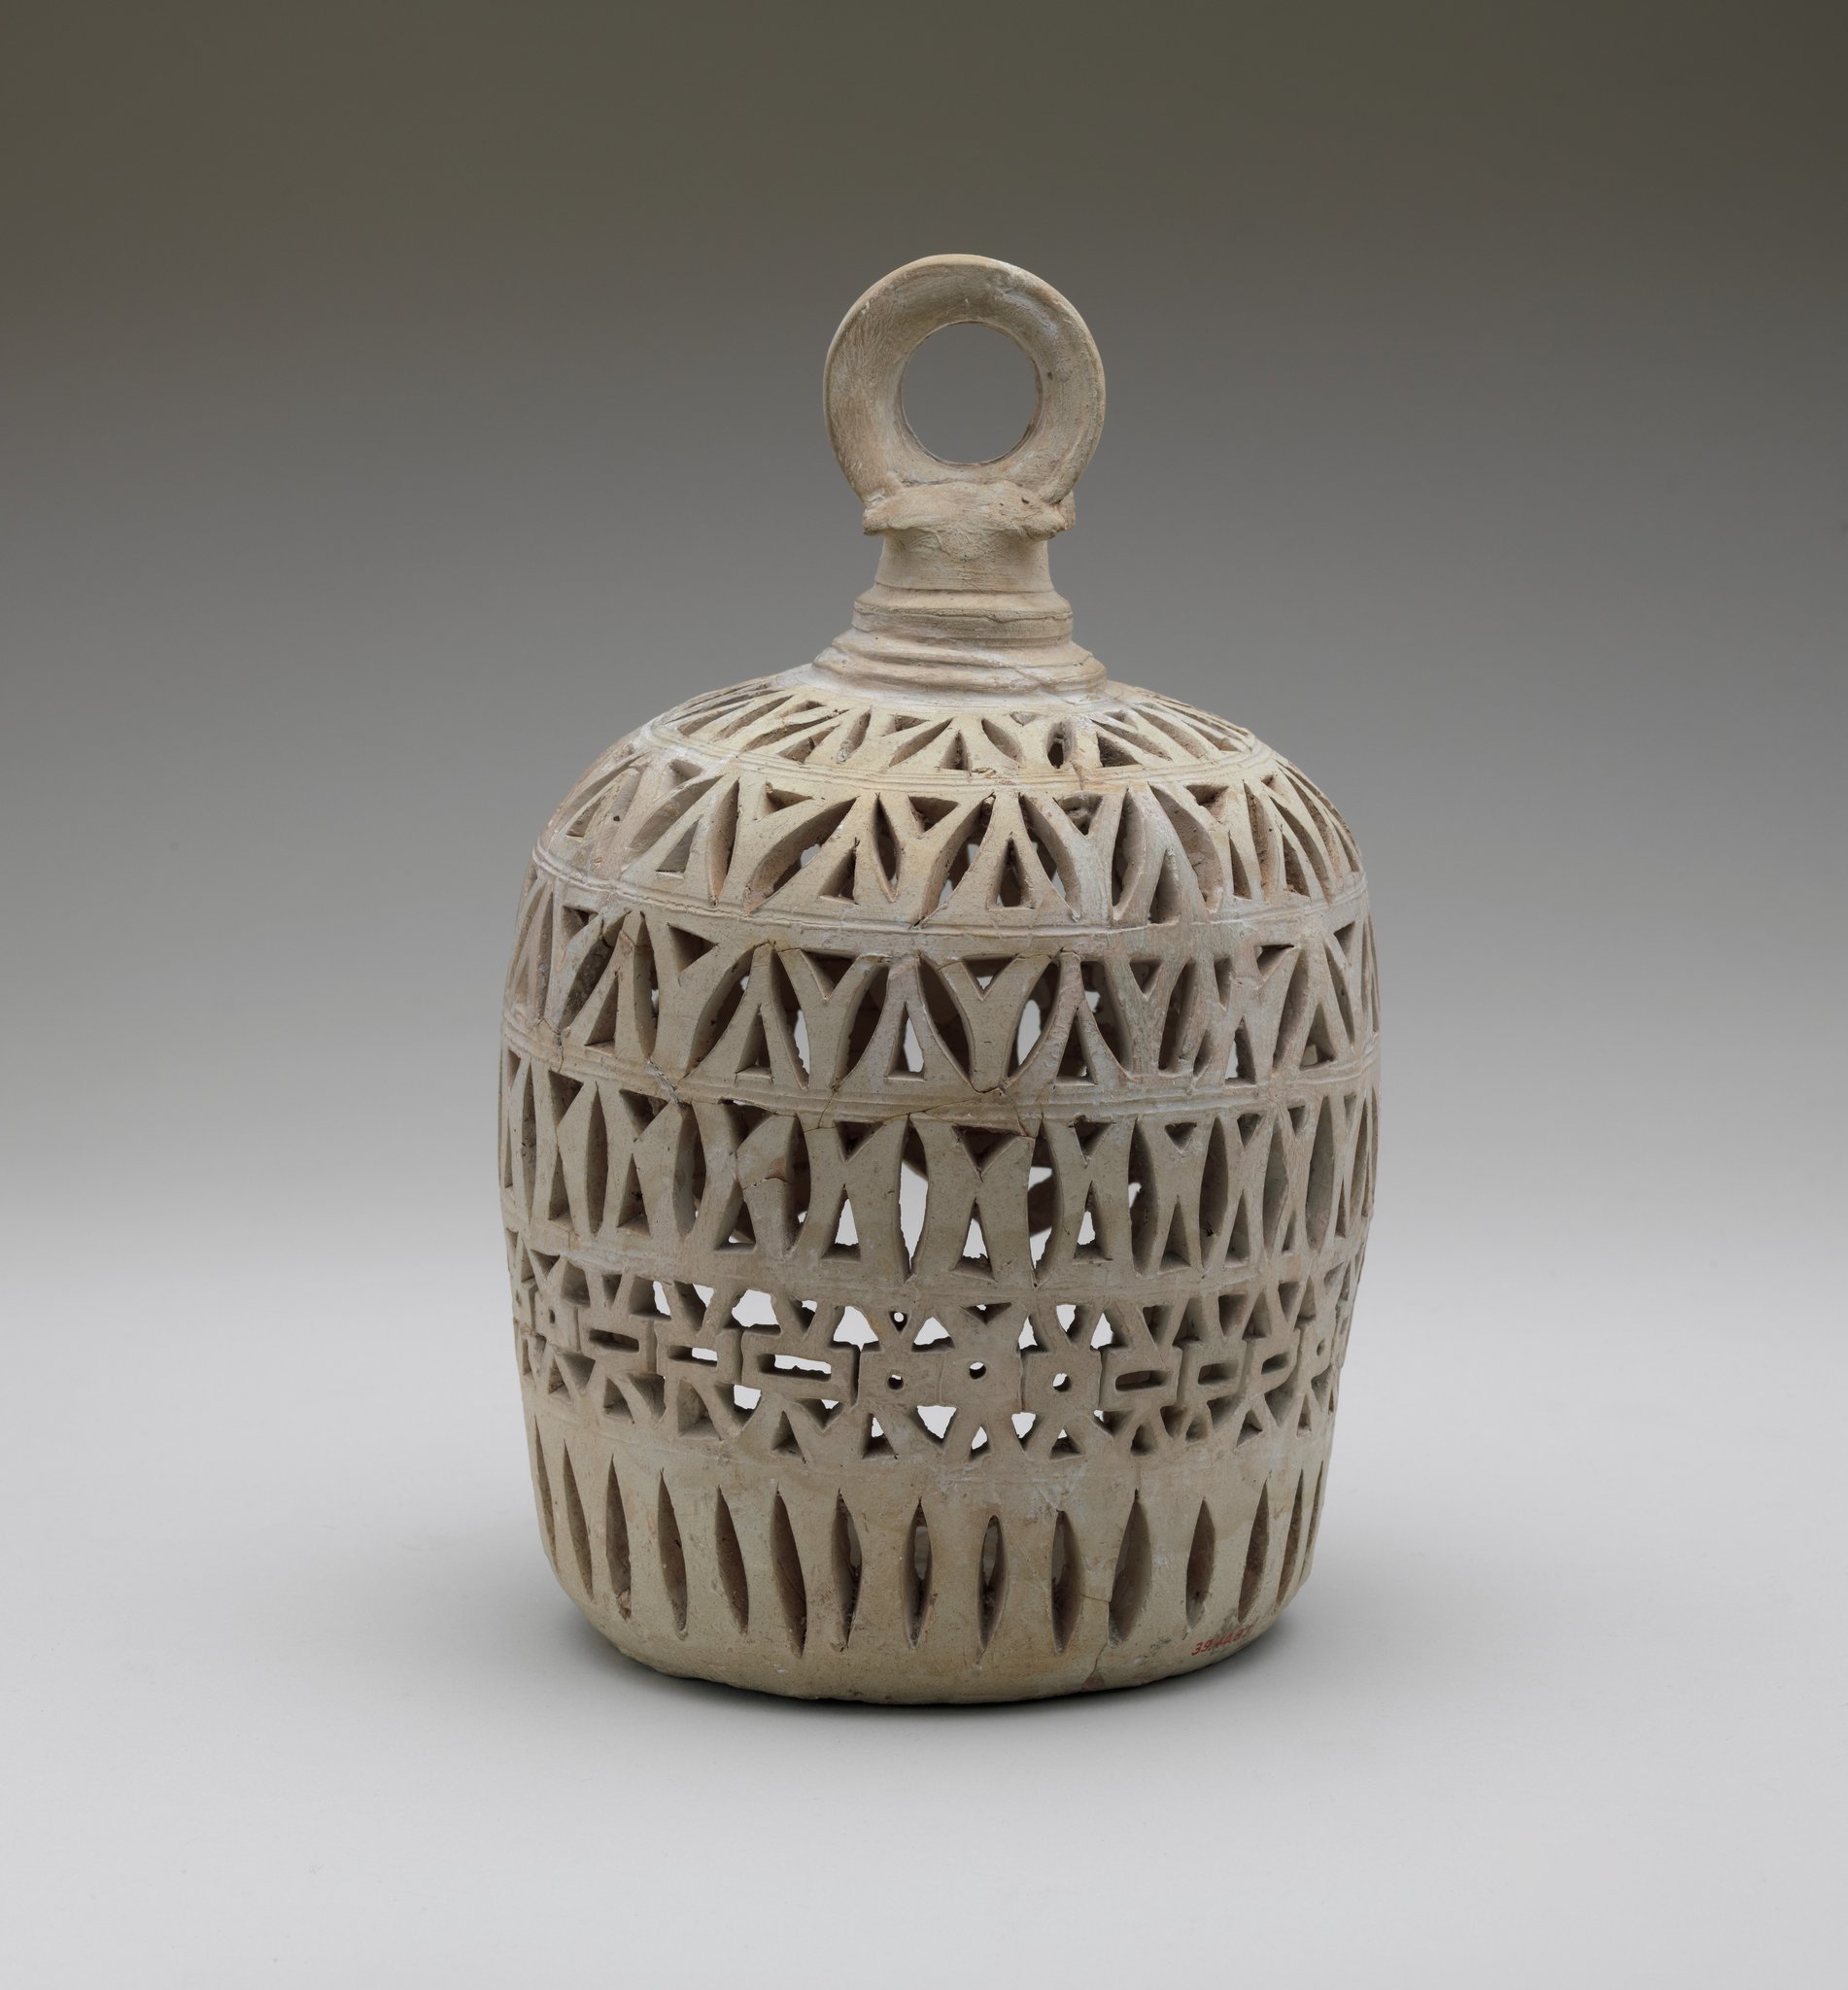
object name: lantern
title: Lantern for a Lamp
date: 801-1000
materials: earthenware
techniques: carving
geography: iran